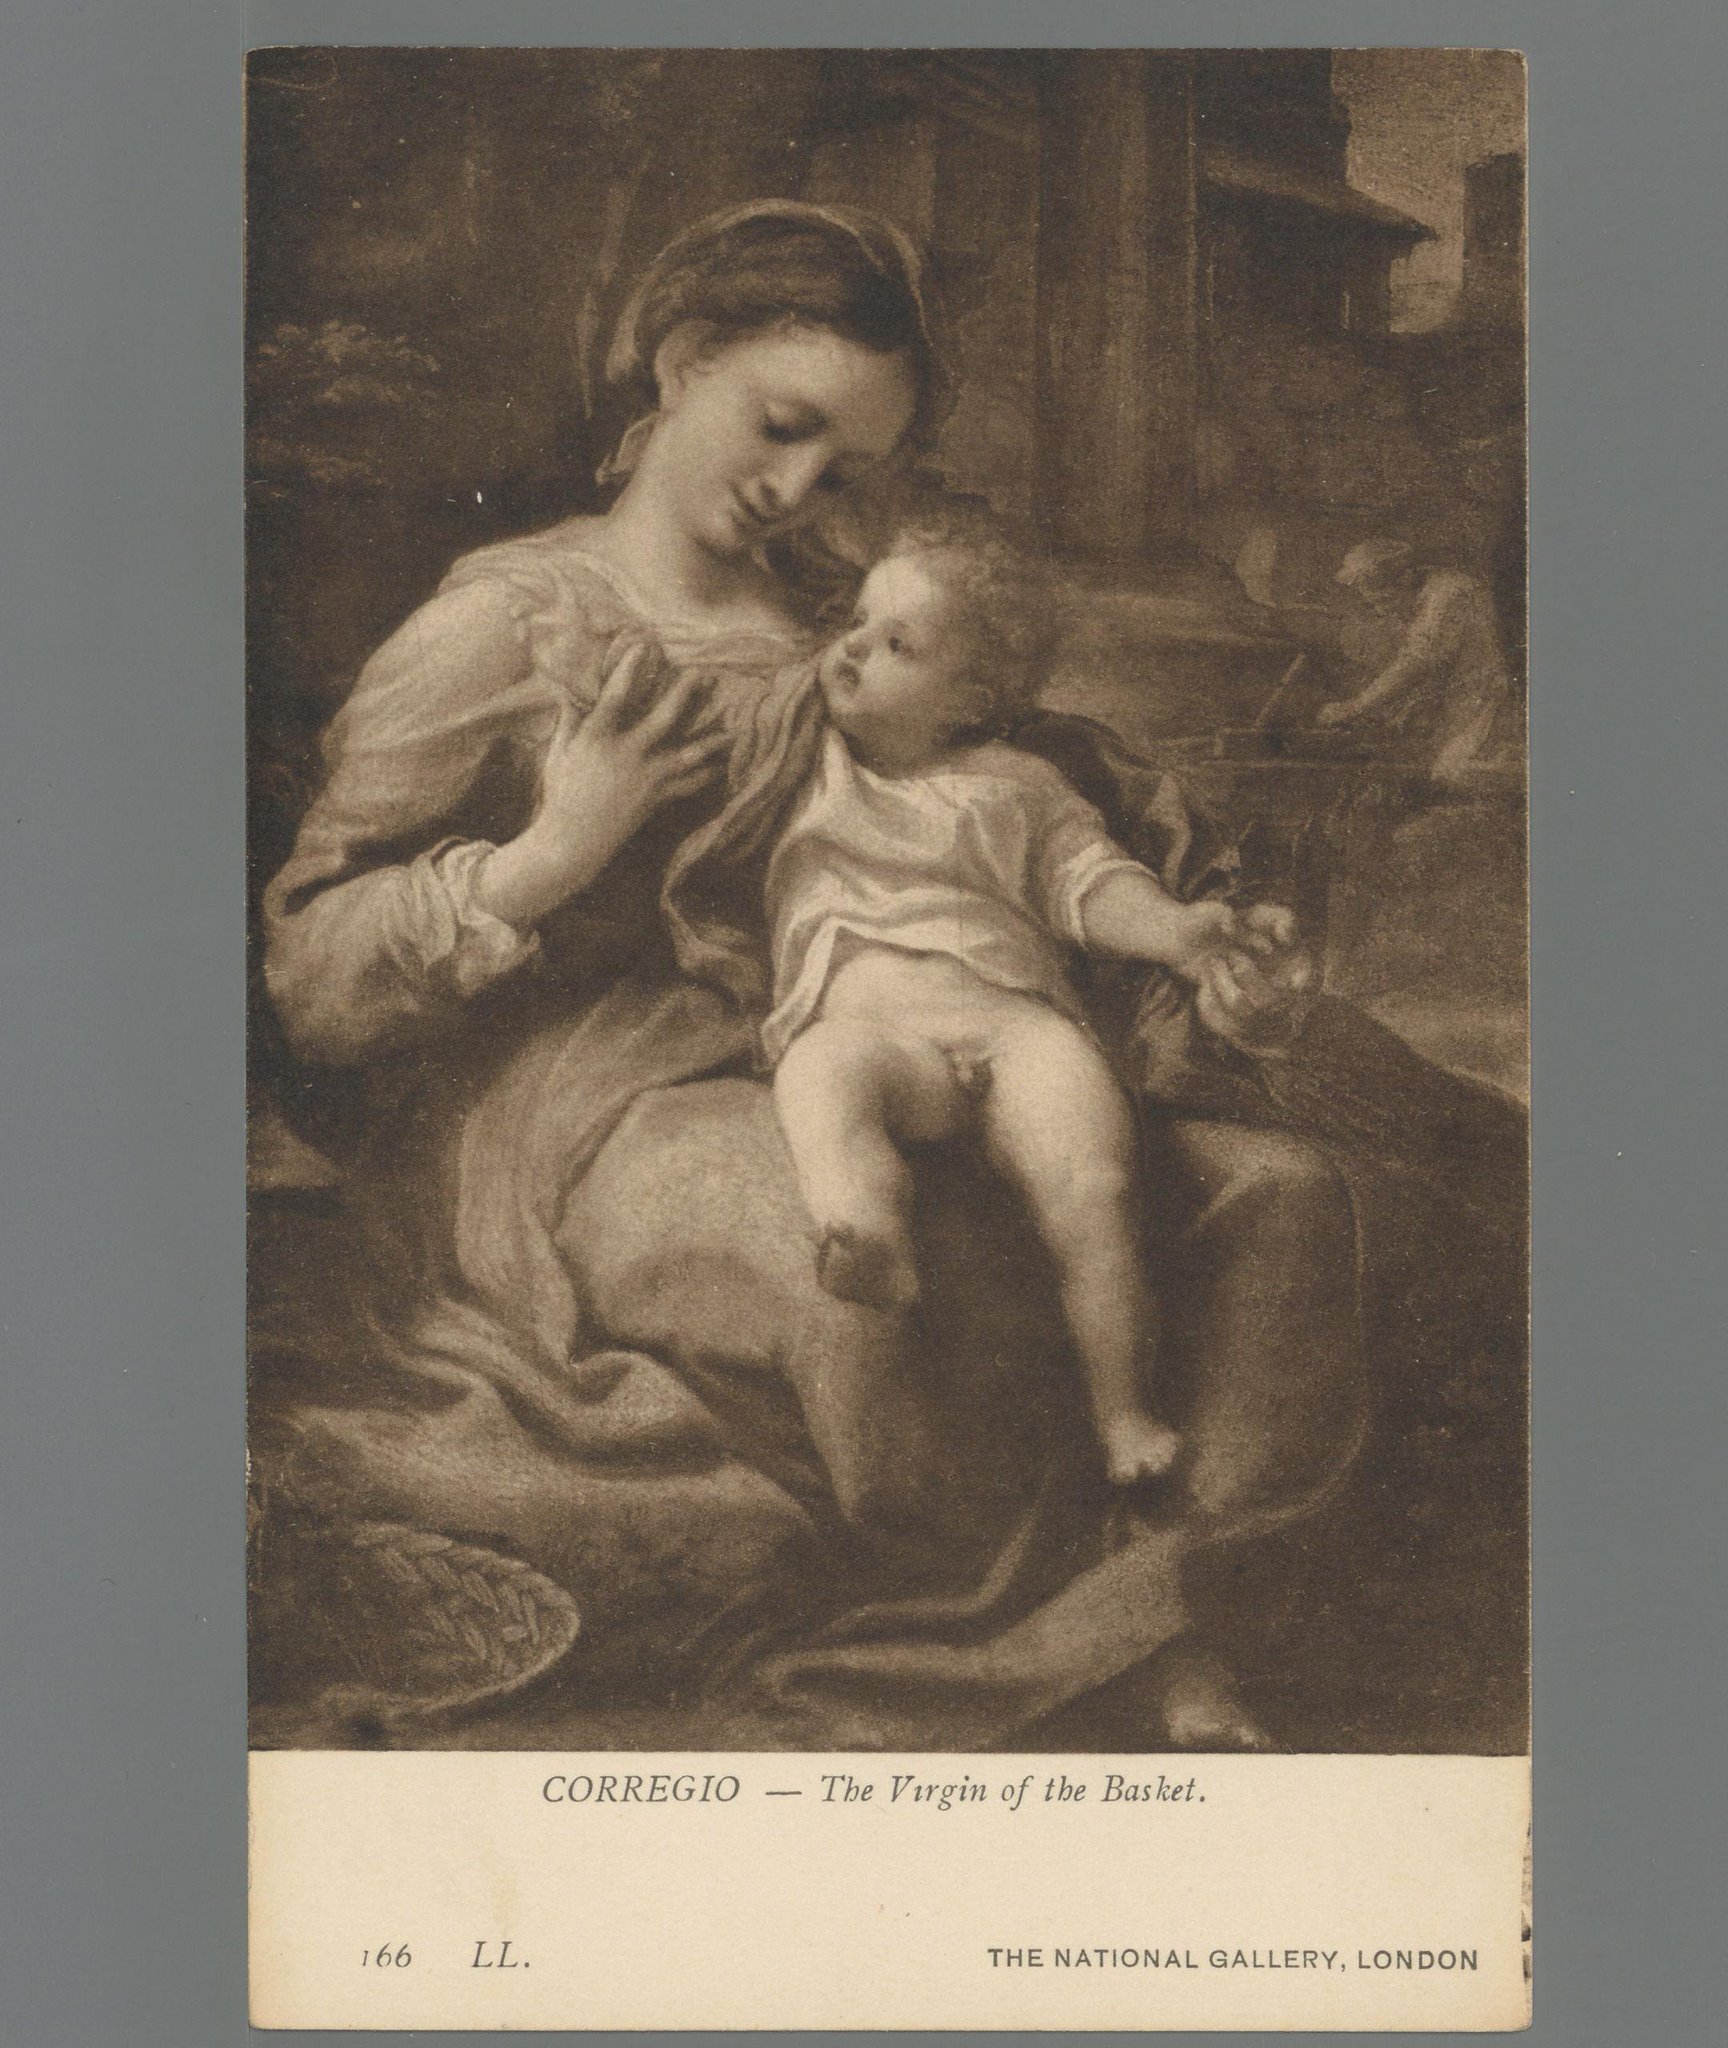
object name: reproduction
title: Corregio - The Virgin of the Basket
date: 1902-1920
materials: cardboard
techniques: photograph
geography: paris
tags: permanent exhibition, museum, picture, painting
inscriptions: collector's mark: ‘AFE v S’